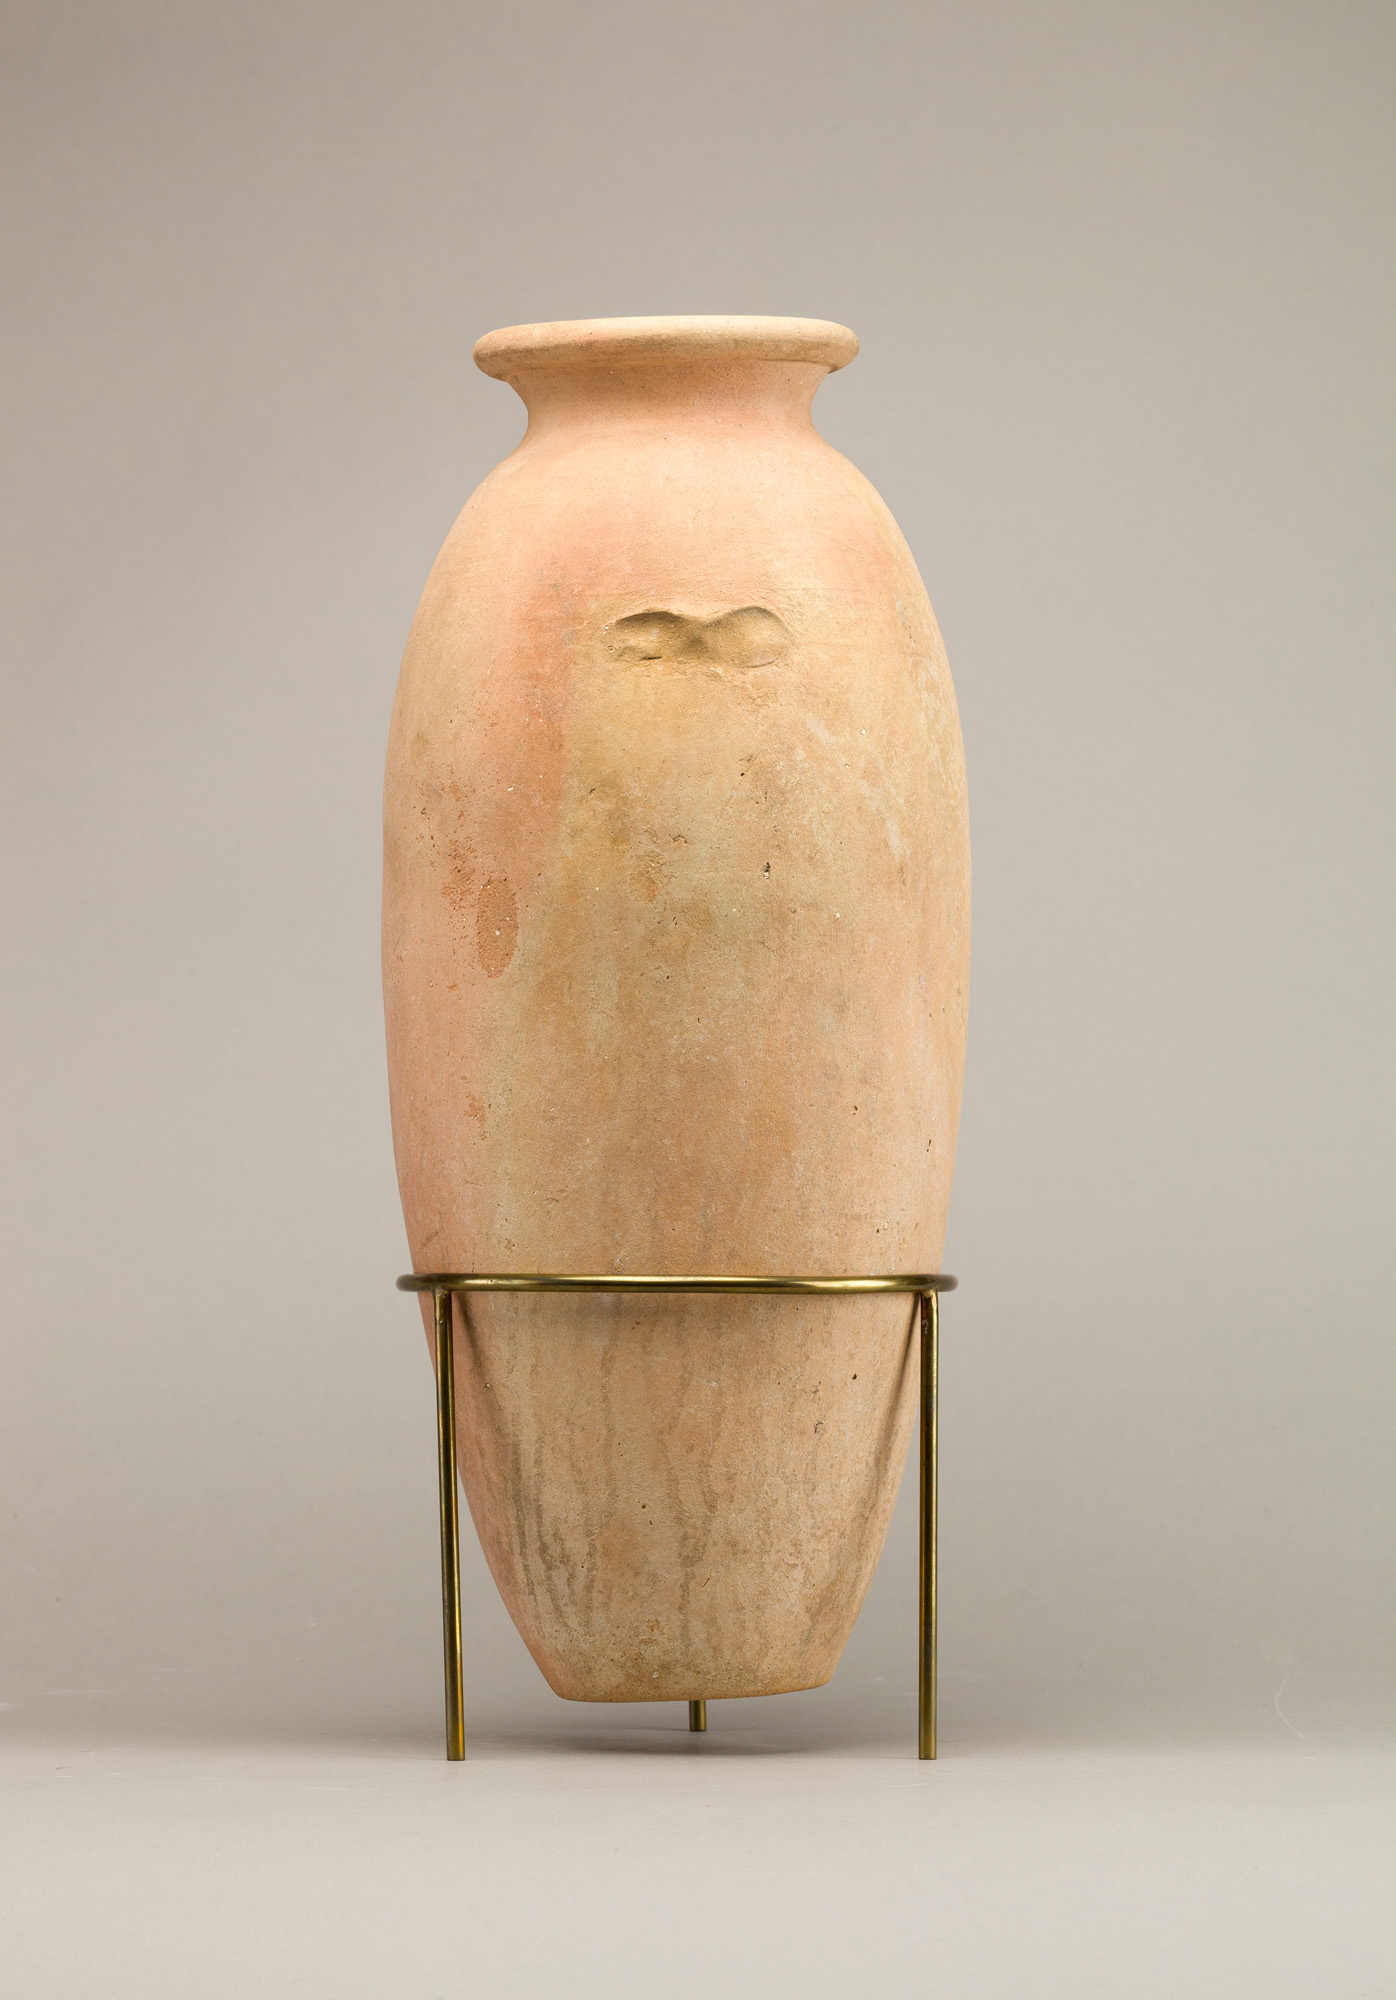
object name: jar, wavy handled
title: Large wavy-handled jar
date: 3850-2960 BCE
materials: pottery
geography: egypt